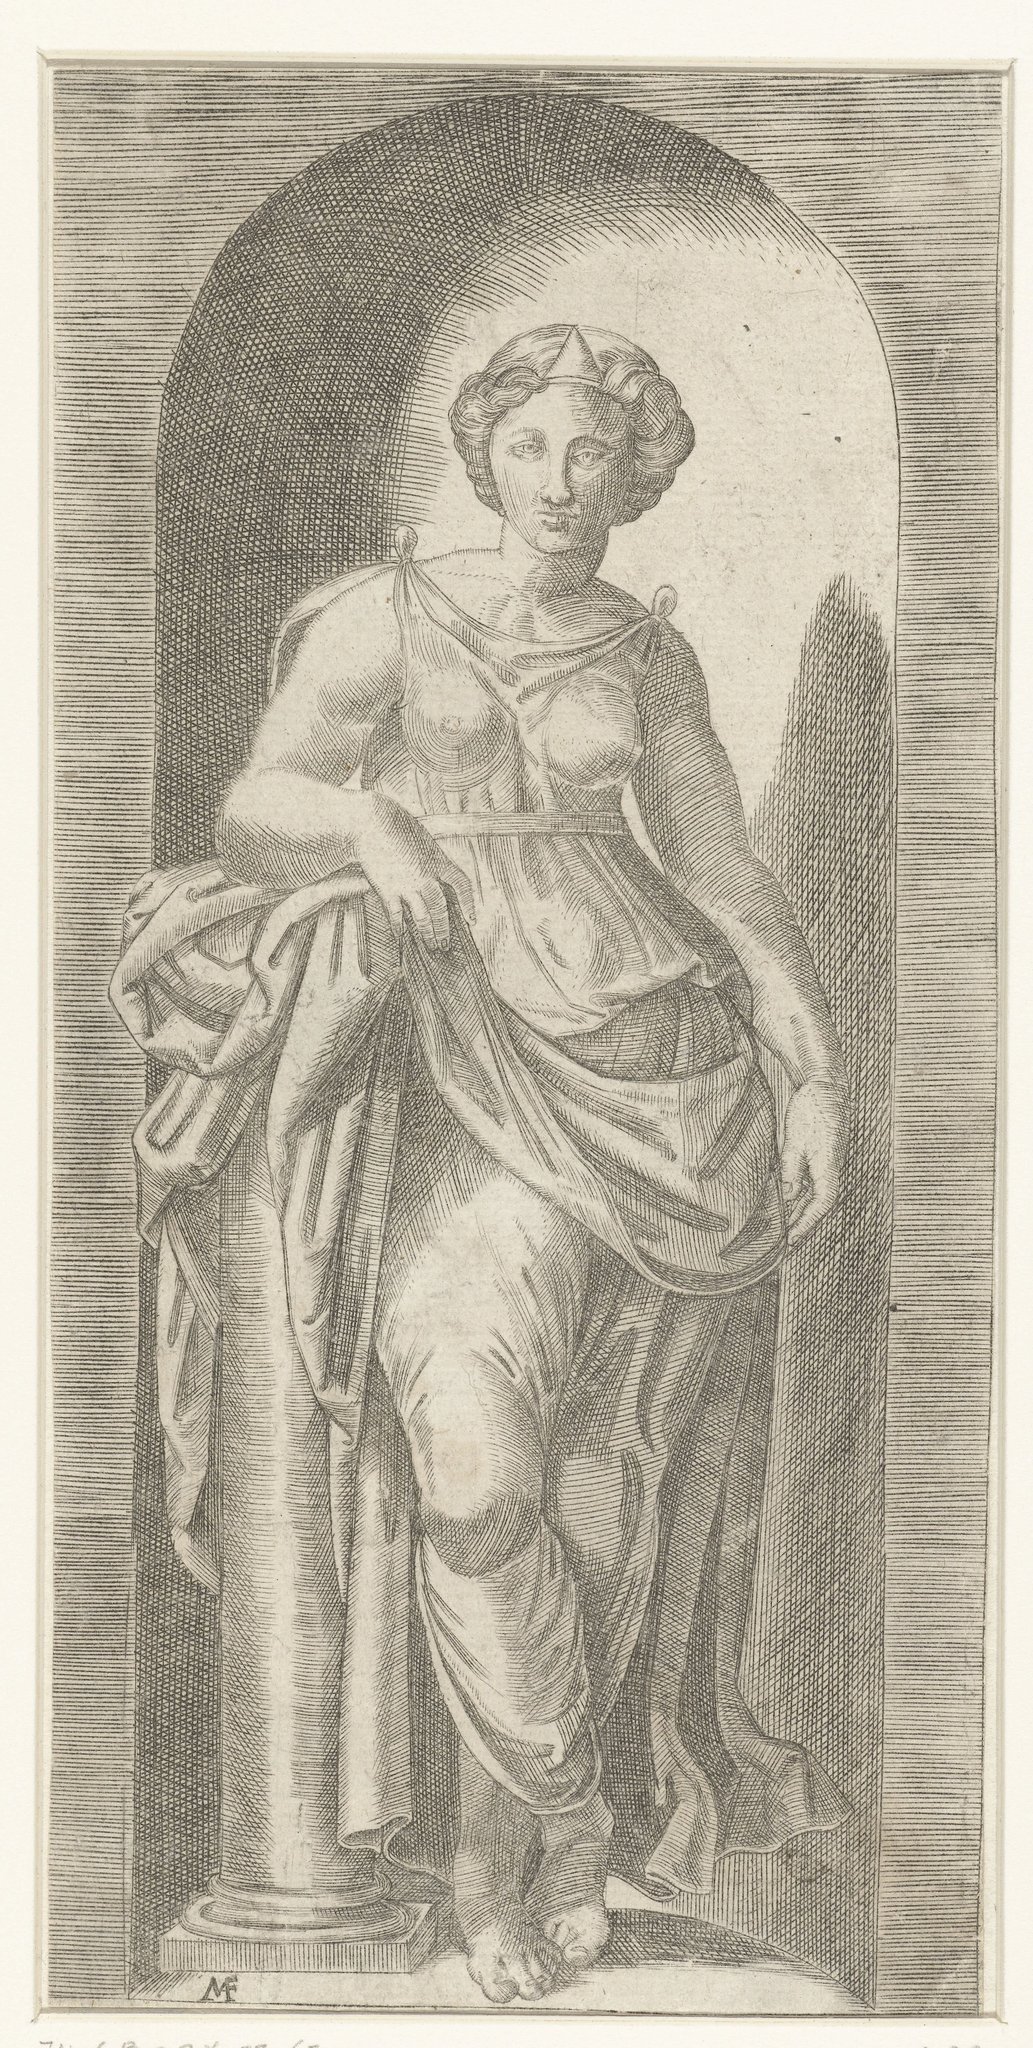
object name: print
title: Zeven Deugden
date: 1510-1575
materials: paper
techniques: engraving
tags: fortitude, 'fortitudo' ~ one of the four cardinal virtues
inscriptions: collector's mark: Lugt 11, inscription: ‘B 28 f 58-65’, collector's mark: Lugt 10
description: Kopie naar prent van Marcantonio Raimondi. Raimondi baseerde zich mogelijk op een ontwerp van Raphael. Prent uit een serie van zeven prenten met Deugden.